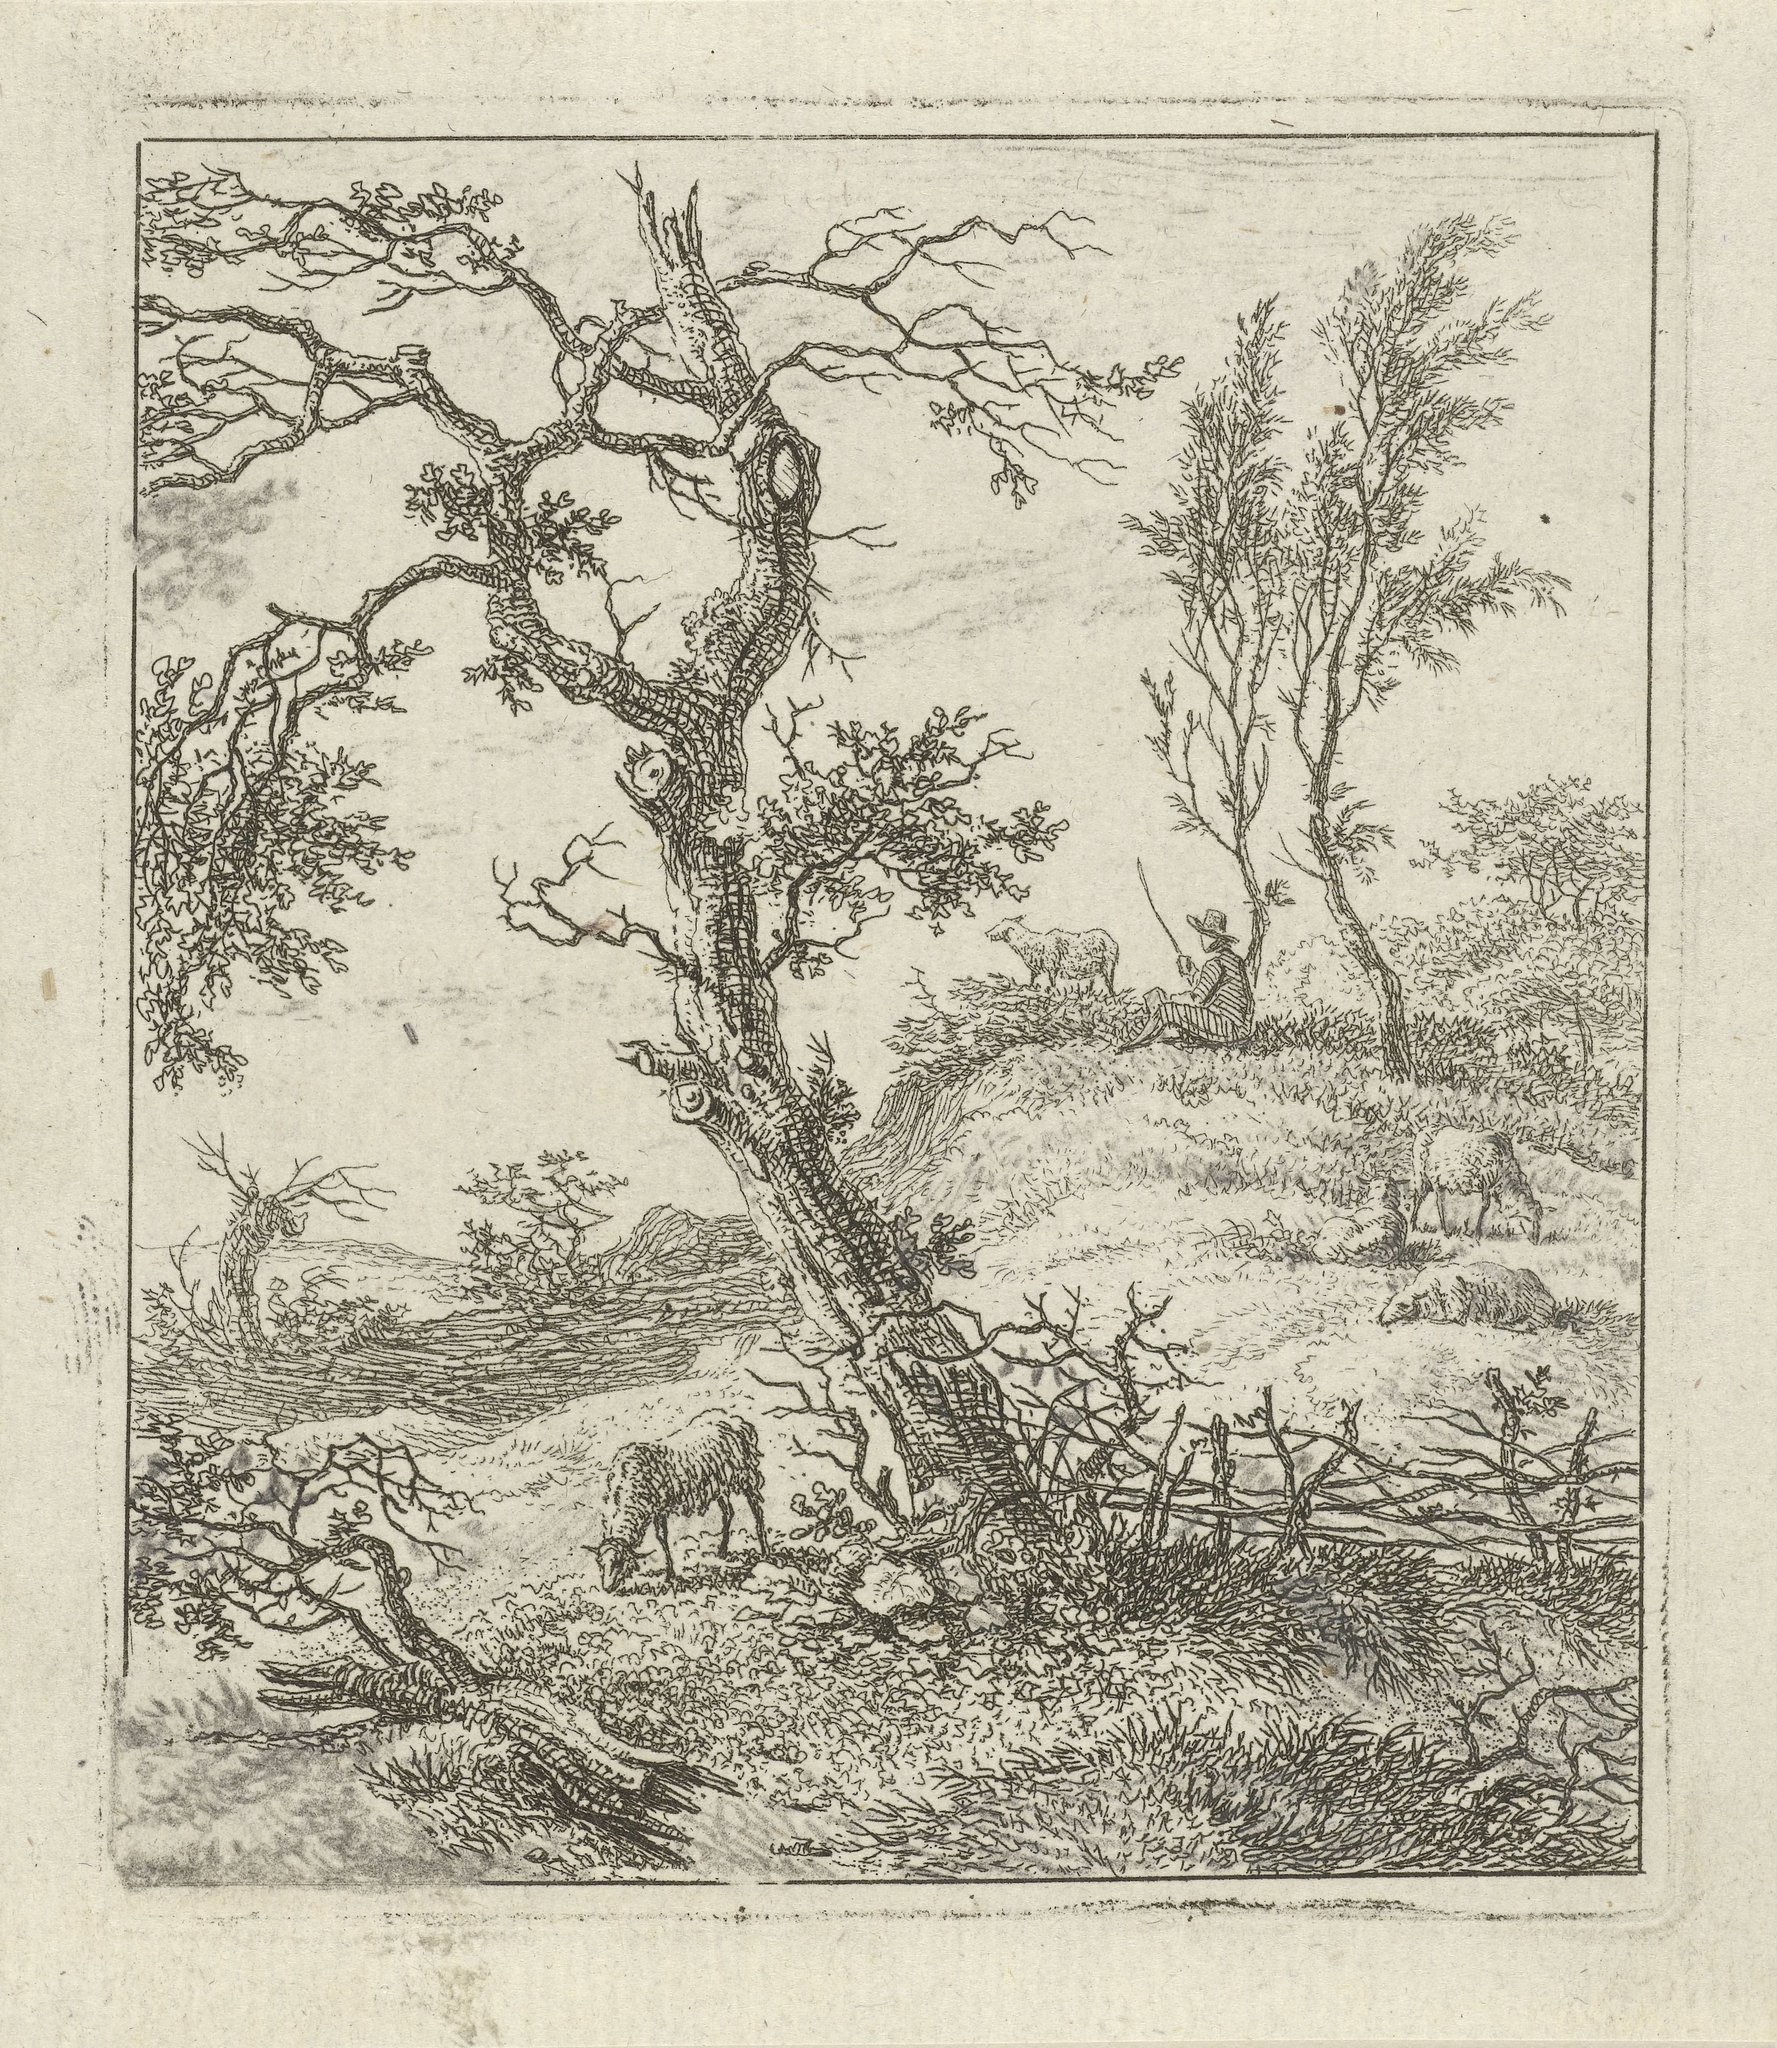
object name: print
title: Landschap met schaapsherder op heuvel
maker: hermanus fock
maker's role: conservator, draughtsman, painter, print maker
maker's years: 1766-1822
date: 1781-1822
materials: paper, pencil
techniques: etching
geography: amsterdam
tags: sheep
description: Een glooiend landschap met op de voorgrond een grazend schaap naast een boom. Op de achtergrond zit een schaapsherder op een heuvel.